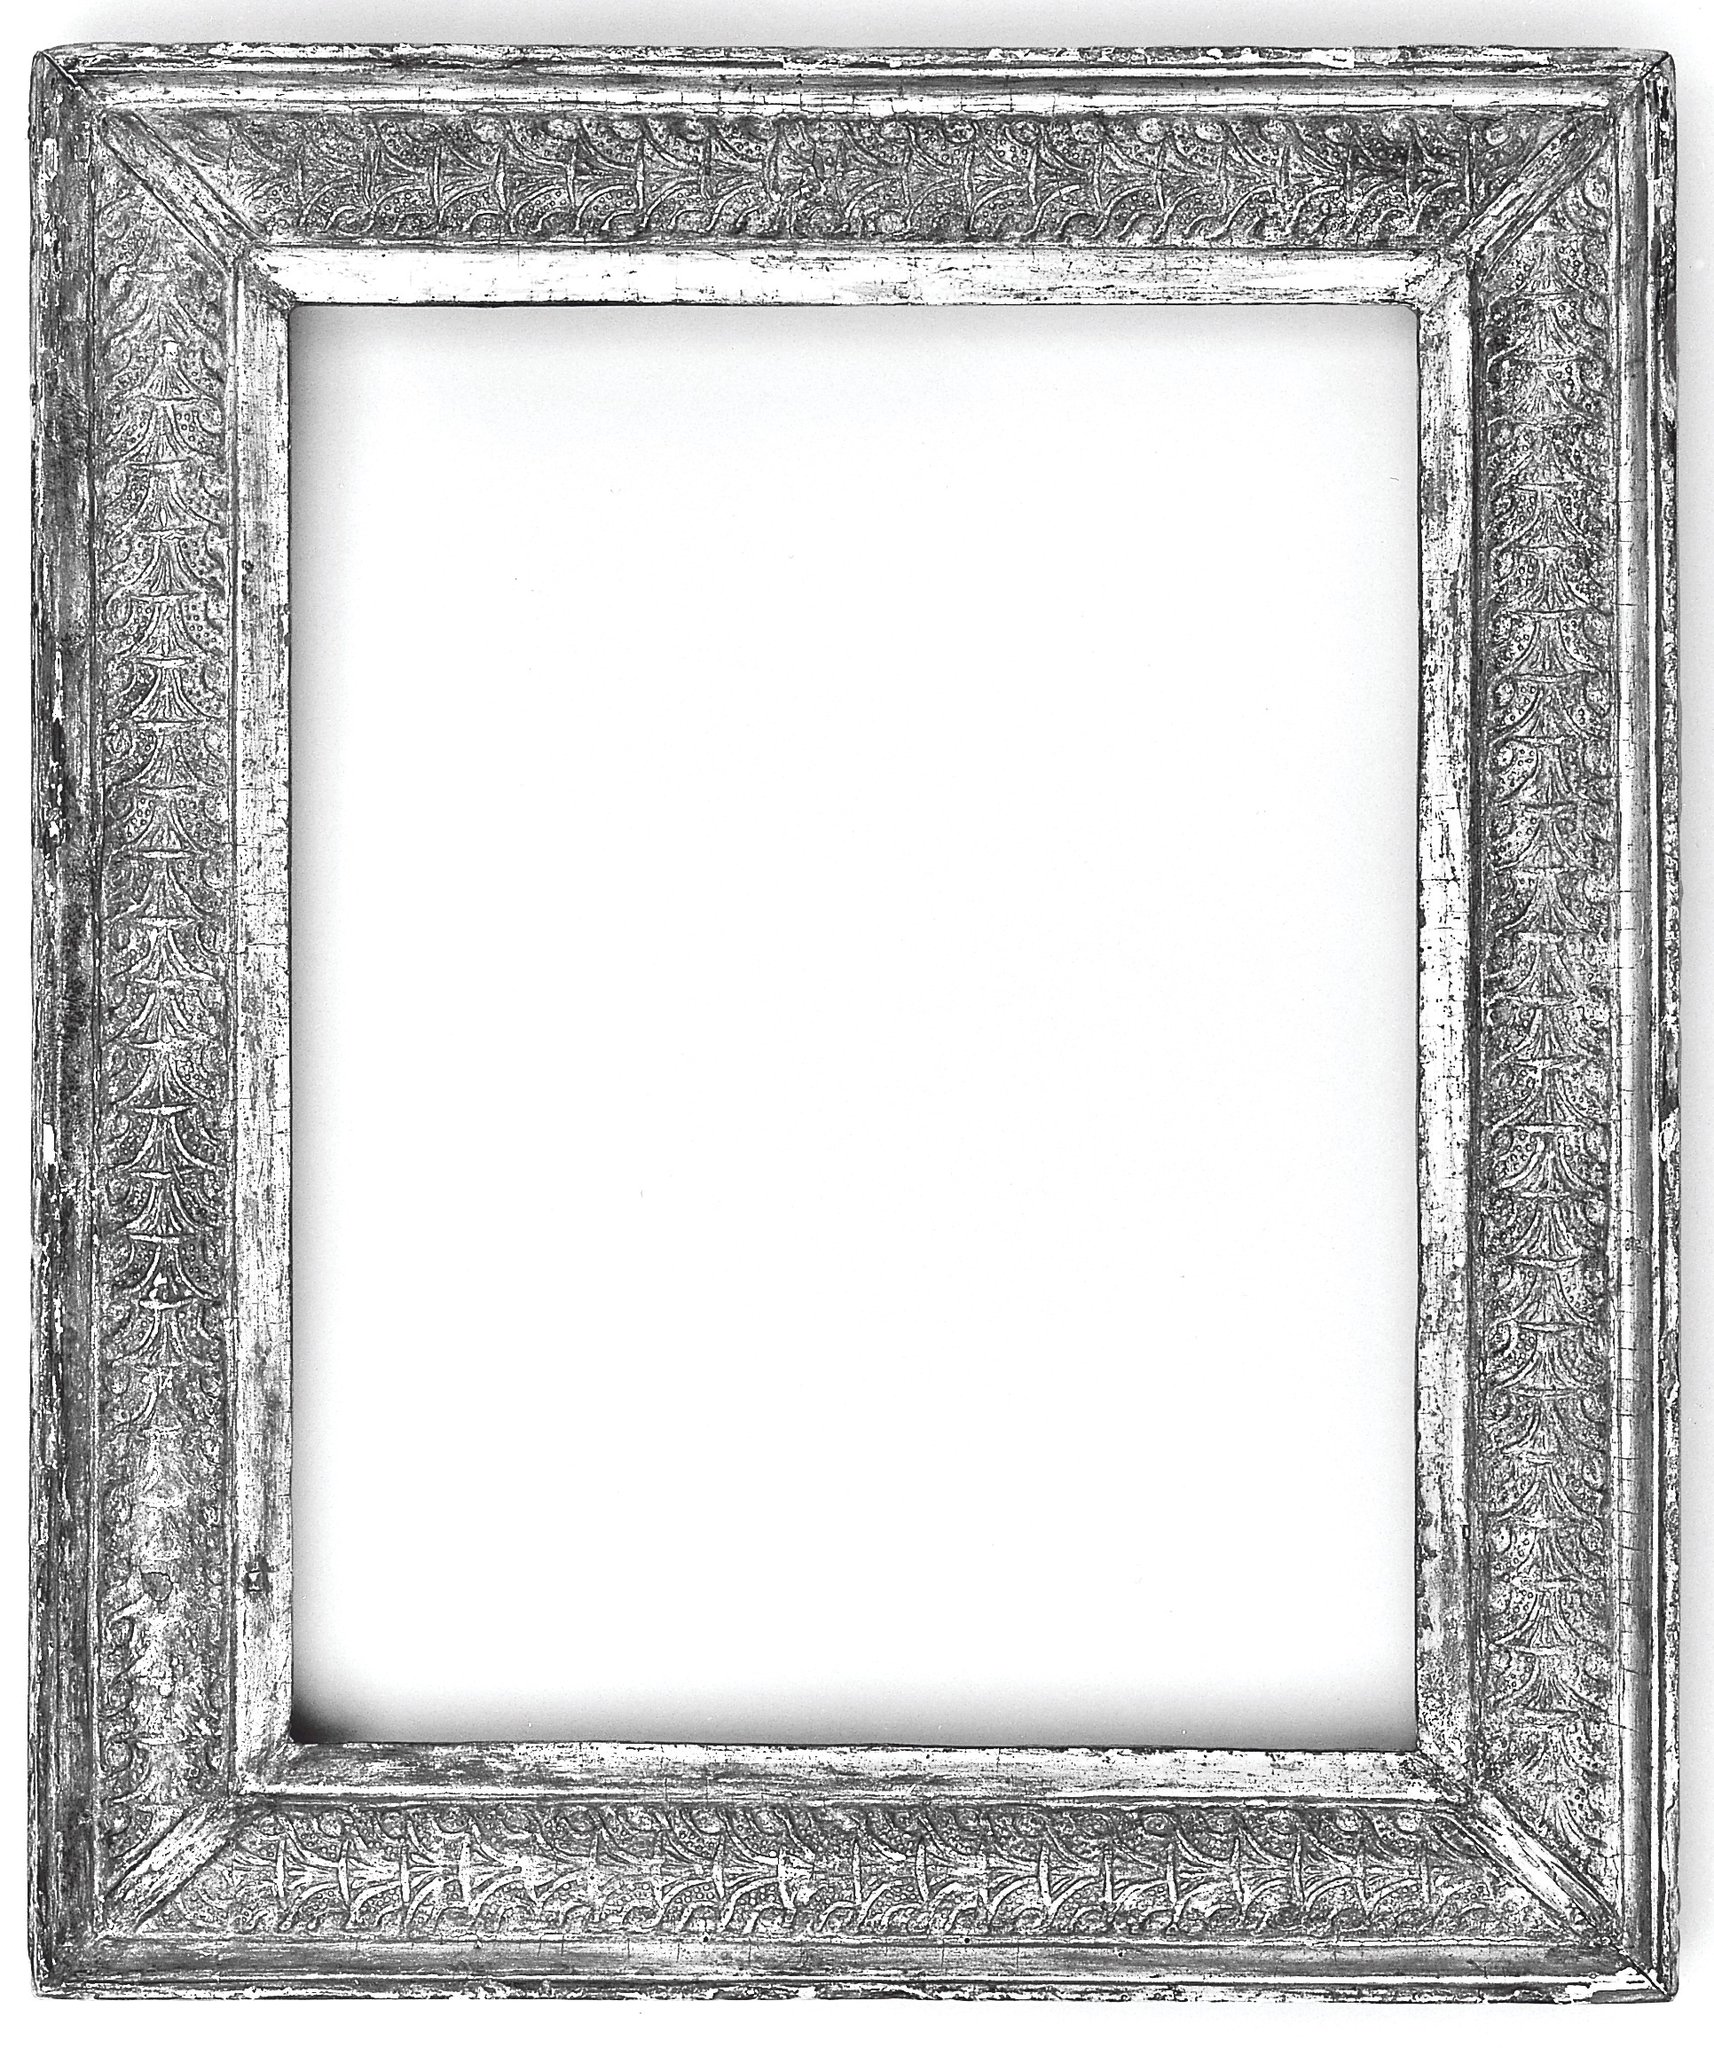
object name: frame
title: Cassetta frame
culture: italian, veneto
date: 1534-1566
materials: wood